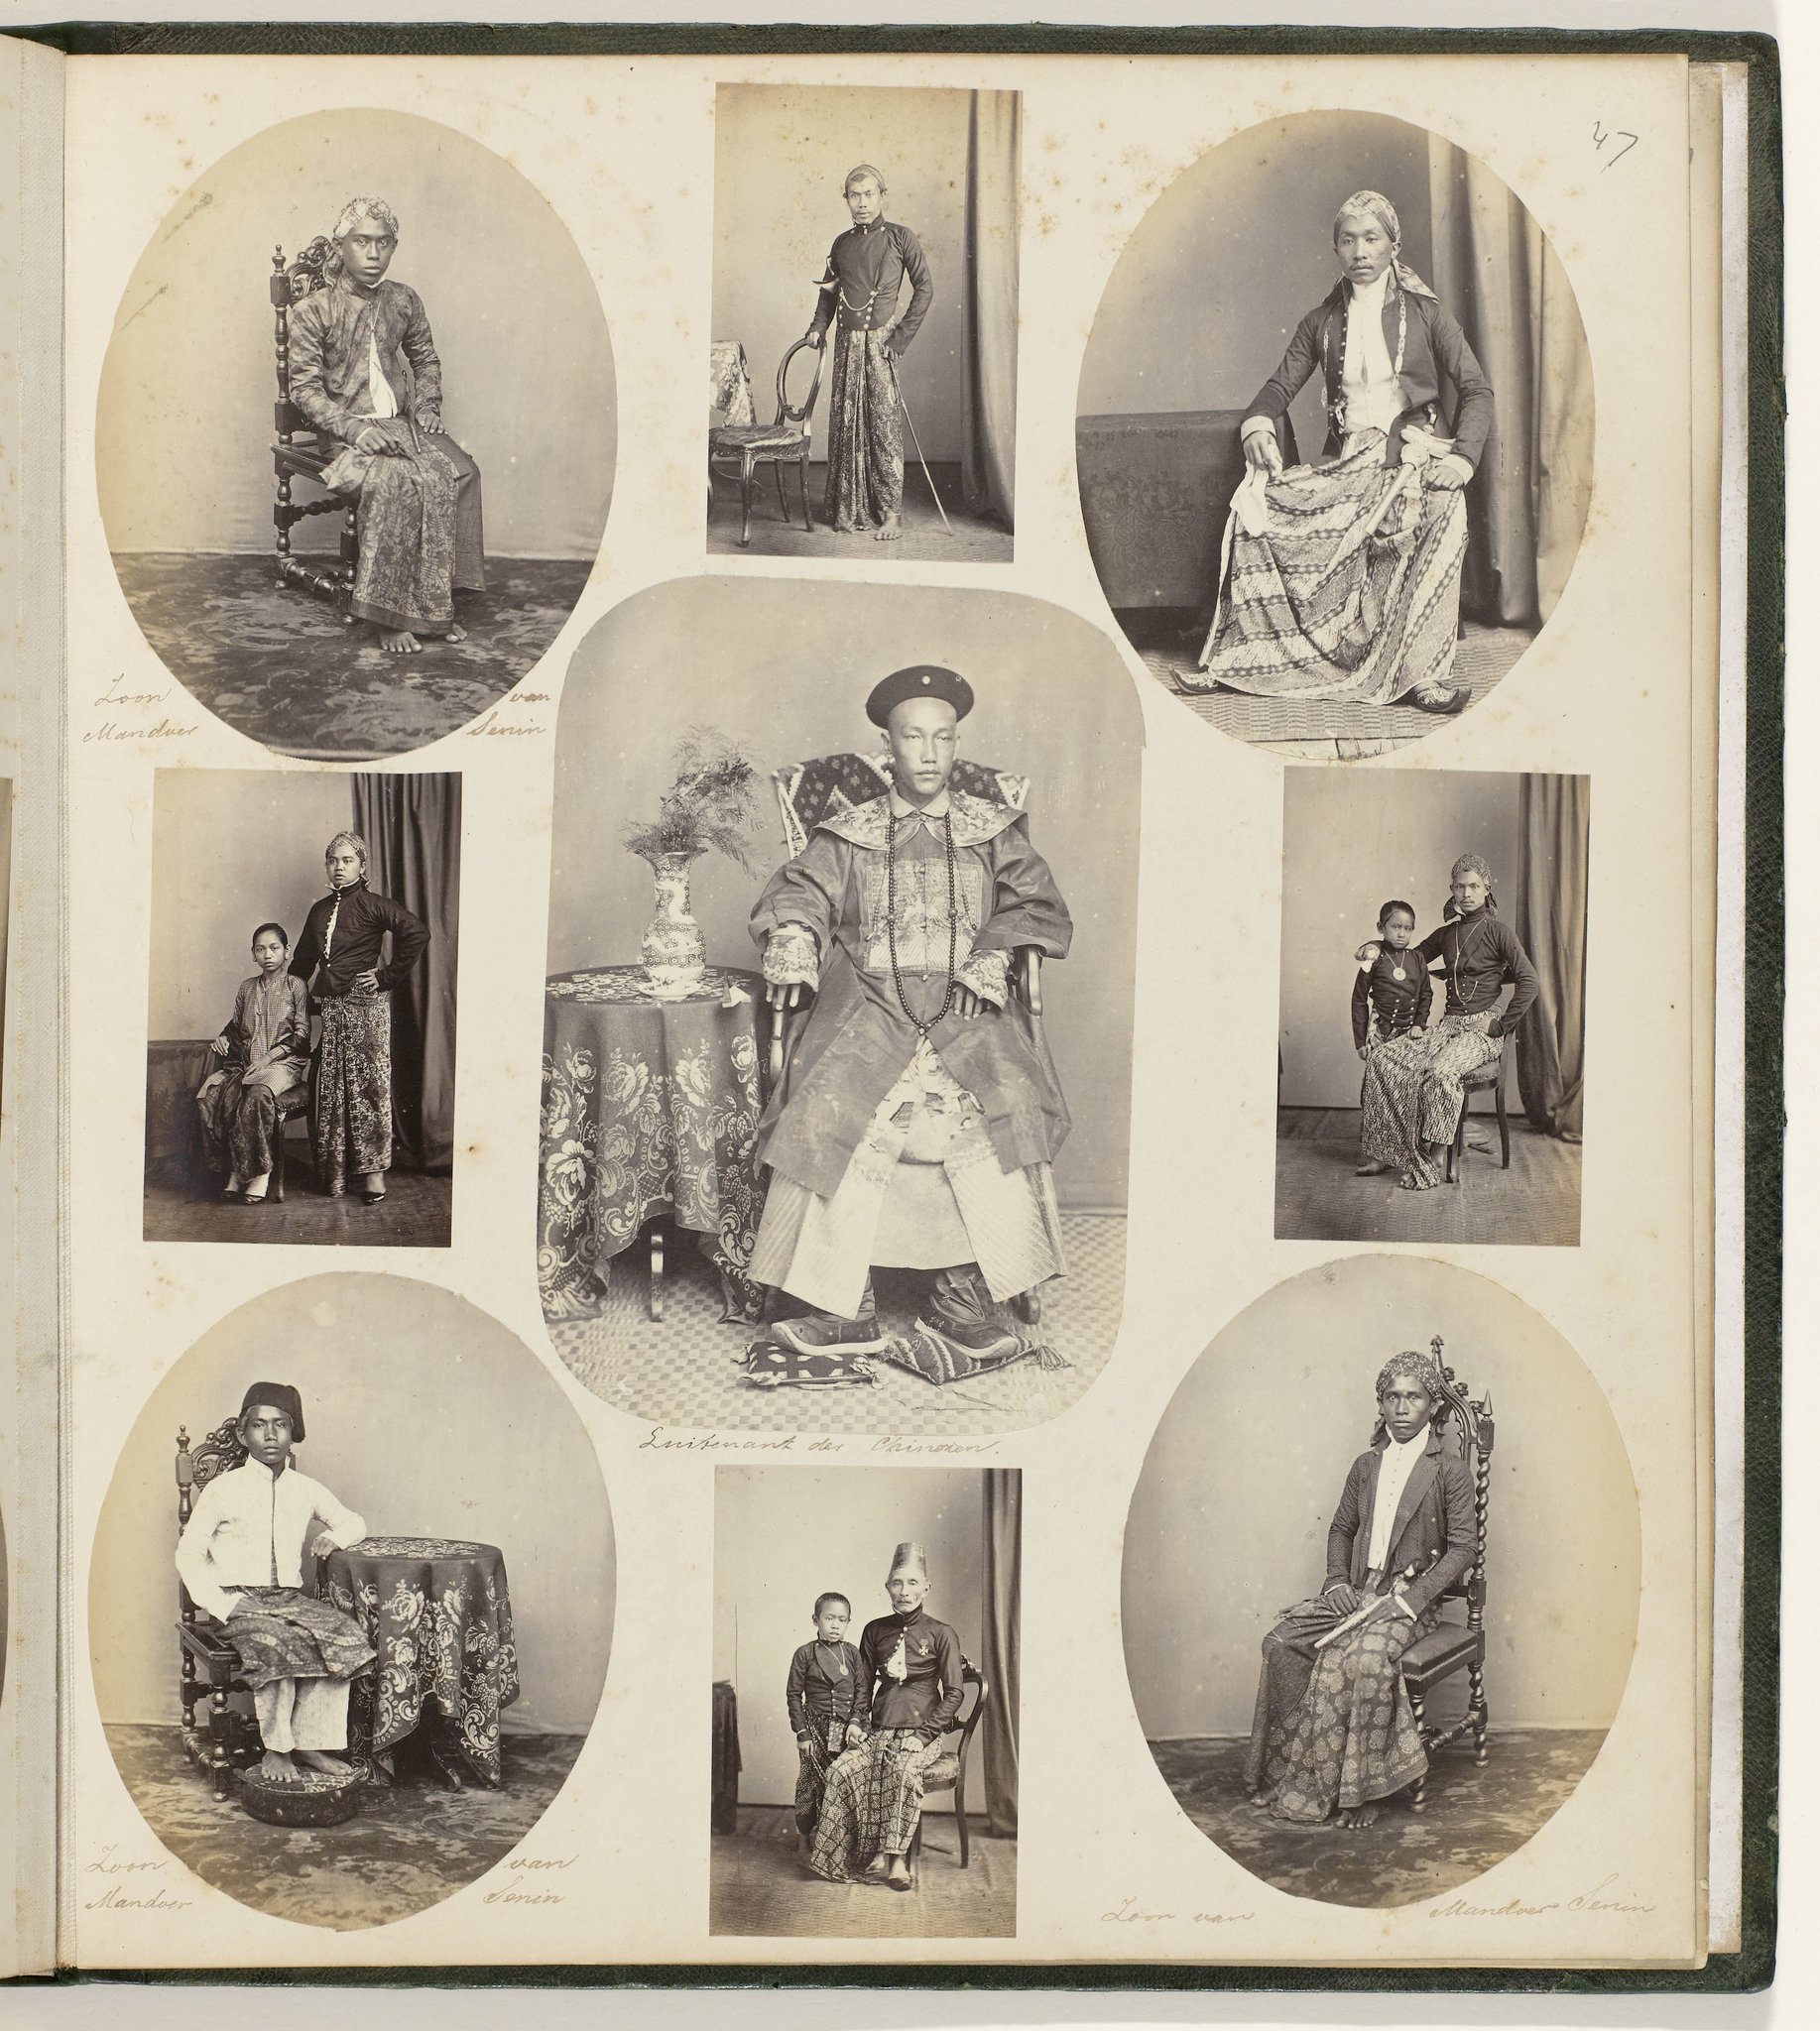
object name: photograph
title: Indische hoogwaardigheidsbekleders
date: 1863-1866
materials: cardboard, photographic support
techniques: albumen print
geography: batavia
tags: ruler, sovereign, historical persons not known by name, batavia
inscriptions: inscription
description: Albumblad met negen studioportretten van Javaanse hoogwaardigheidsbekleders, hun zonen en een echtgenote. Centraal een portret van een Chinese luitenant. Verder o.a. drie foto's van de zoon van de Mandoer Senin. Onderdeel van het tweede groene fotoalbum met foto's van Java, uit het bezit van apotheker Specht-Grijp, die in 1865 vanuit Batavia naar Nederland terugkeerde.